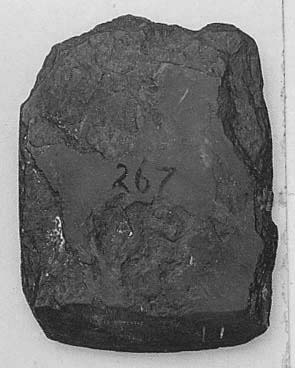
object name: knife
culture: north american, alaskan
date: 1902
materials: jade